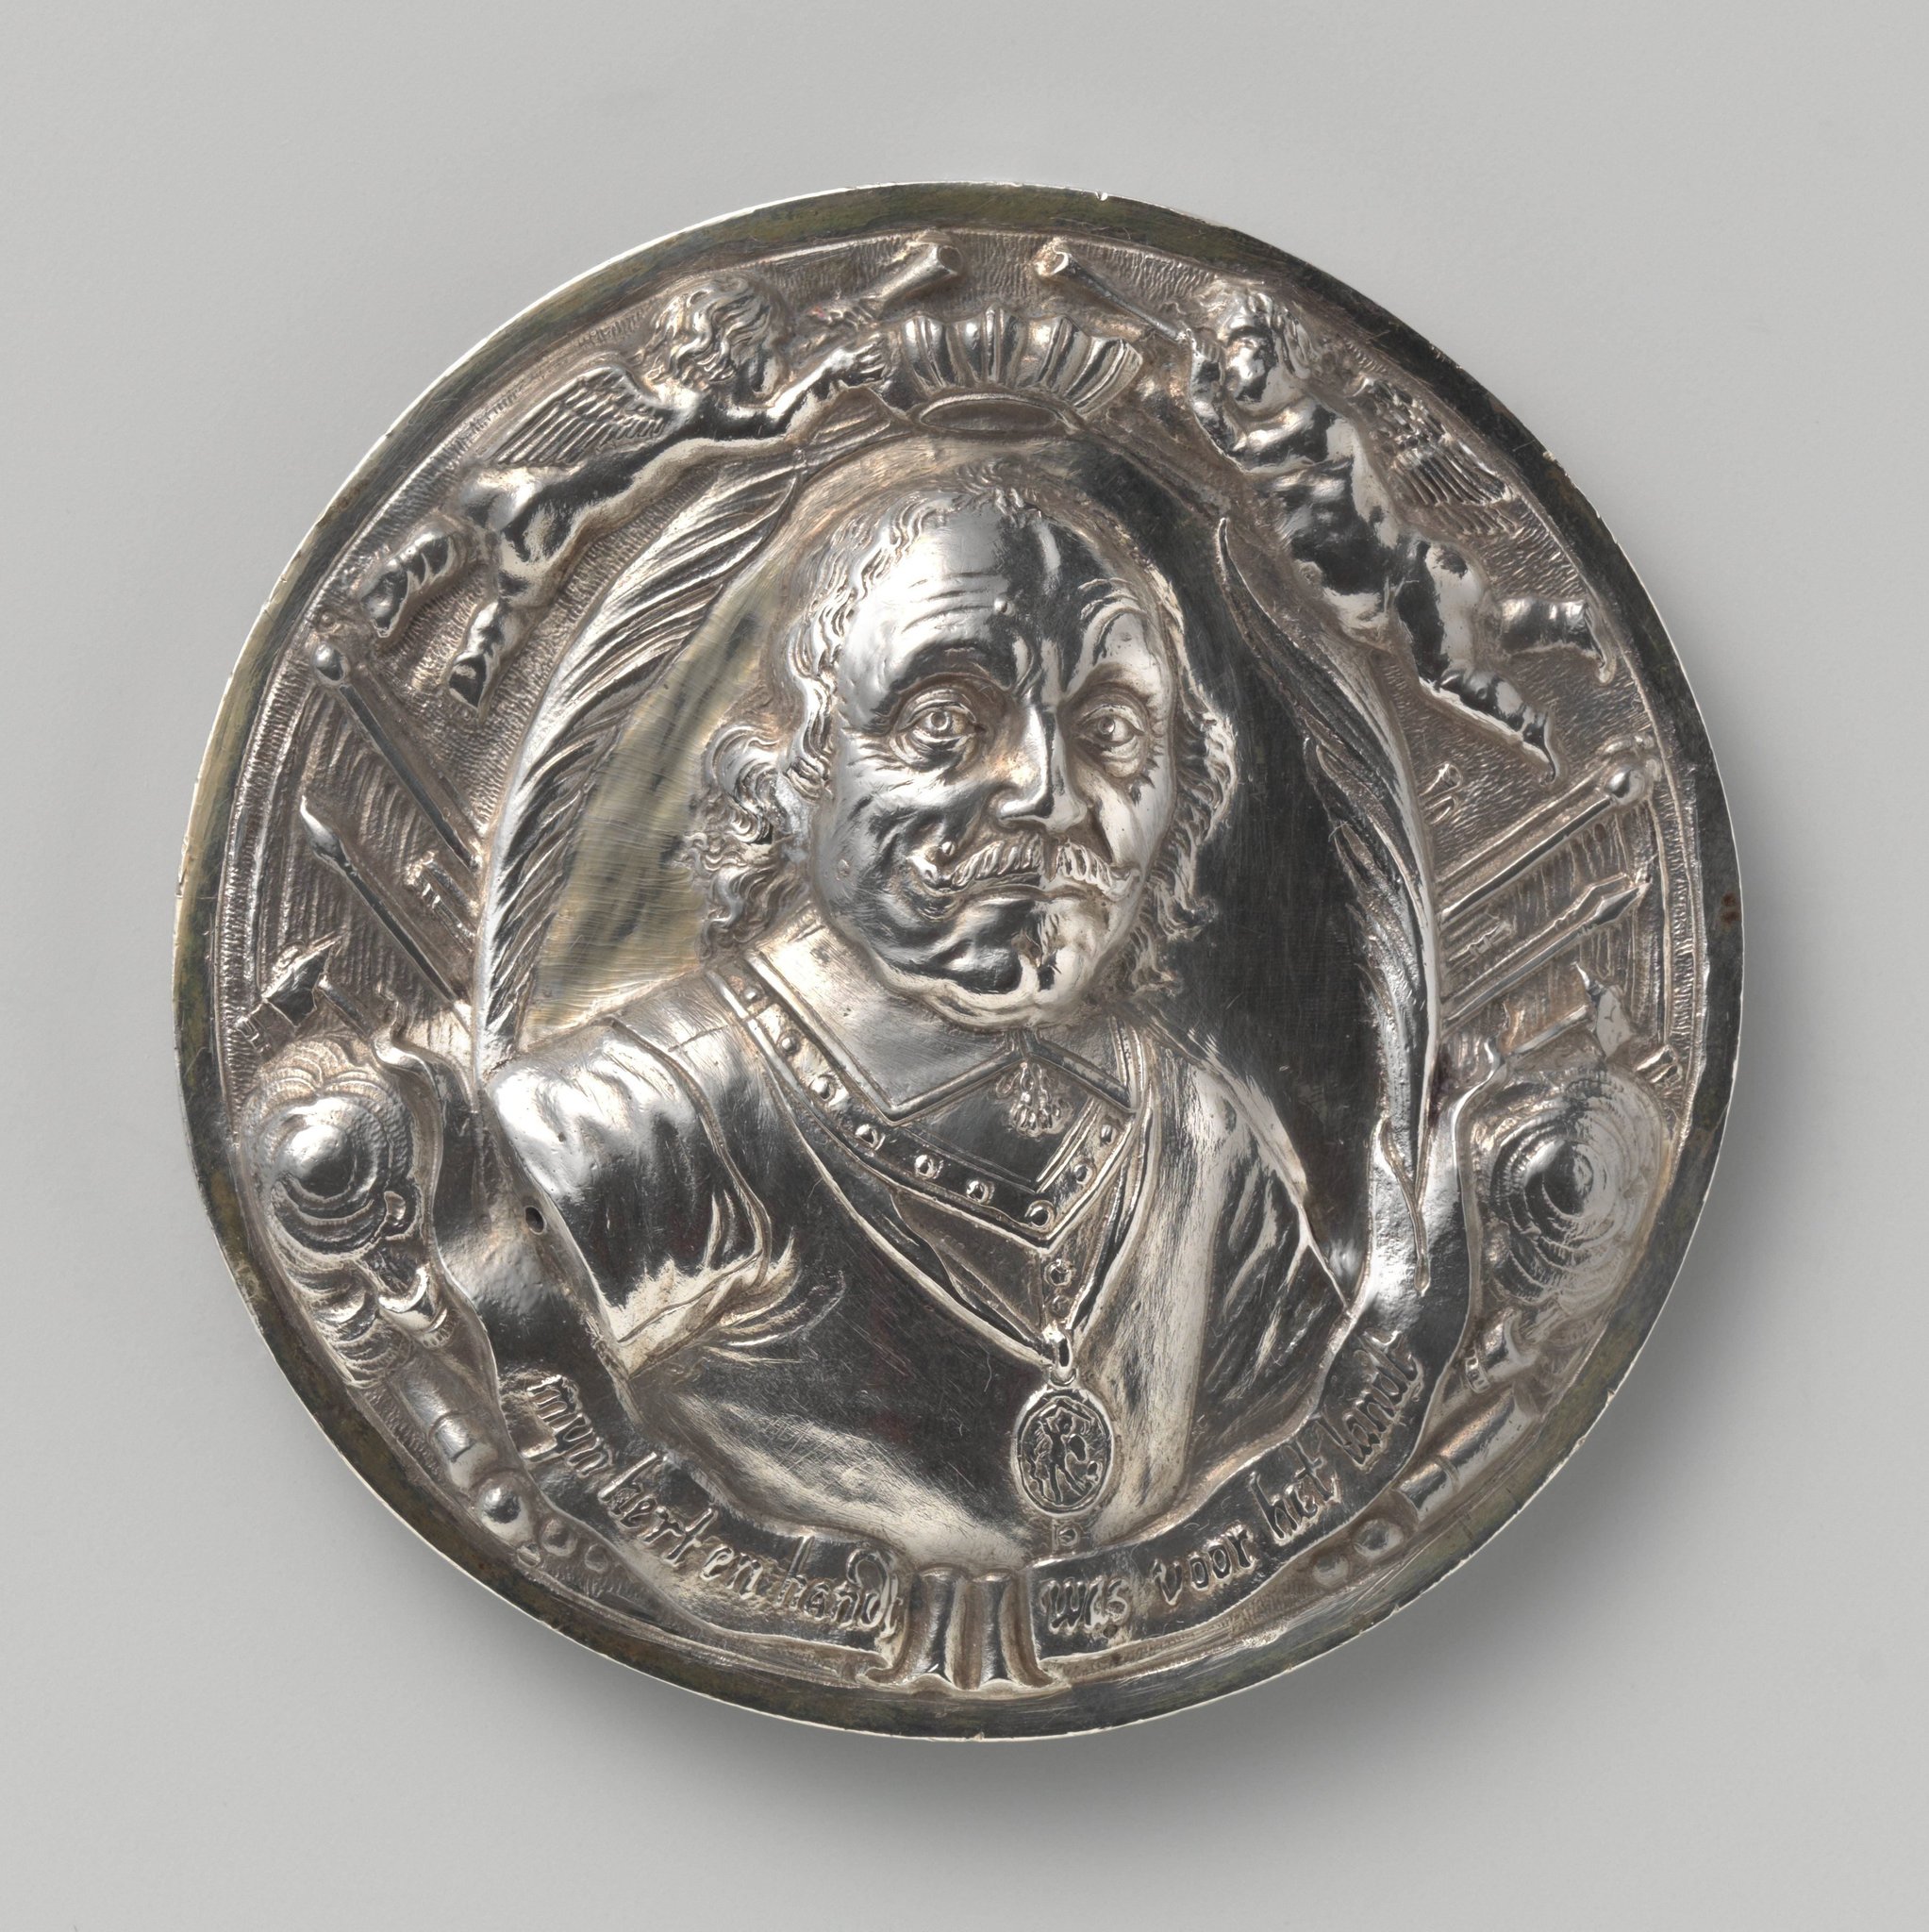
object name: overlijdenspenning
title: Death of Admiral Maarten Harpertsz Tromp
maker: wouter muller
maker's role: publisher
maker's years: 1604-1673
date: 1653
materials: silver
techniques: casting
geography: amsterdam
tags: maarten harpertszoon tromp, battle of scheveningen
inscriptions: inscription: ‘mijn hert en handt was voor het landt’, inscription: ‘Waarom doet muller Tromp door kunst van goud en silver leeven : om dat hy d'yser eew door krygsdeugd heeft verdreven obyt den 10 aug 1653’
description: Zilveren penning. Voorzijde: borststuk man tussen zegepalmen, scheepsvlaggen en krijgstuig en onder scheepskroon vastgehouden door twee engeltjes met bazuinen, met opschrift. Keerzijde: zeeslag binnen omschrift.